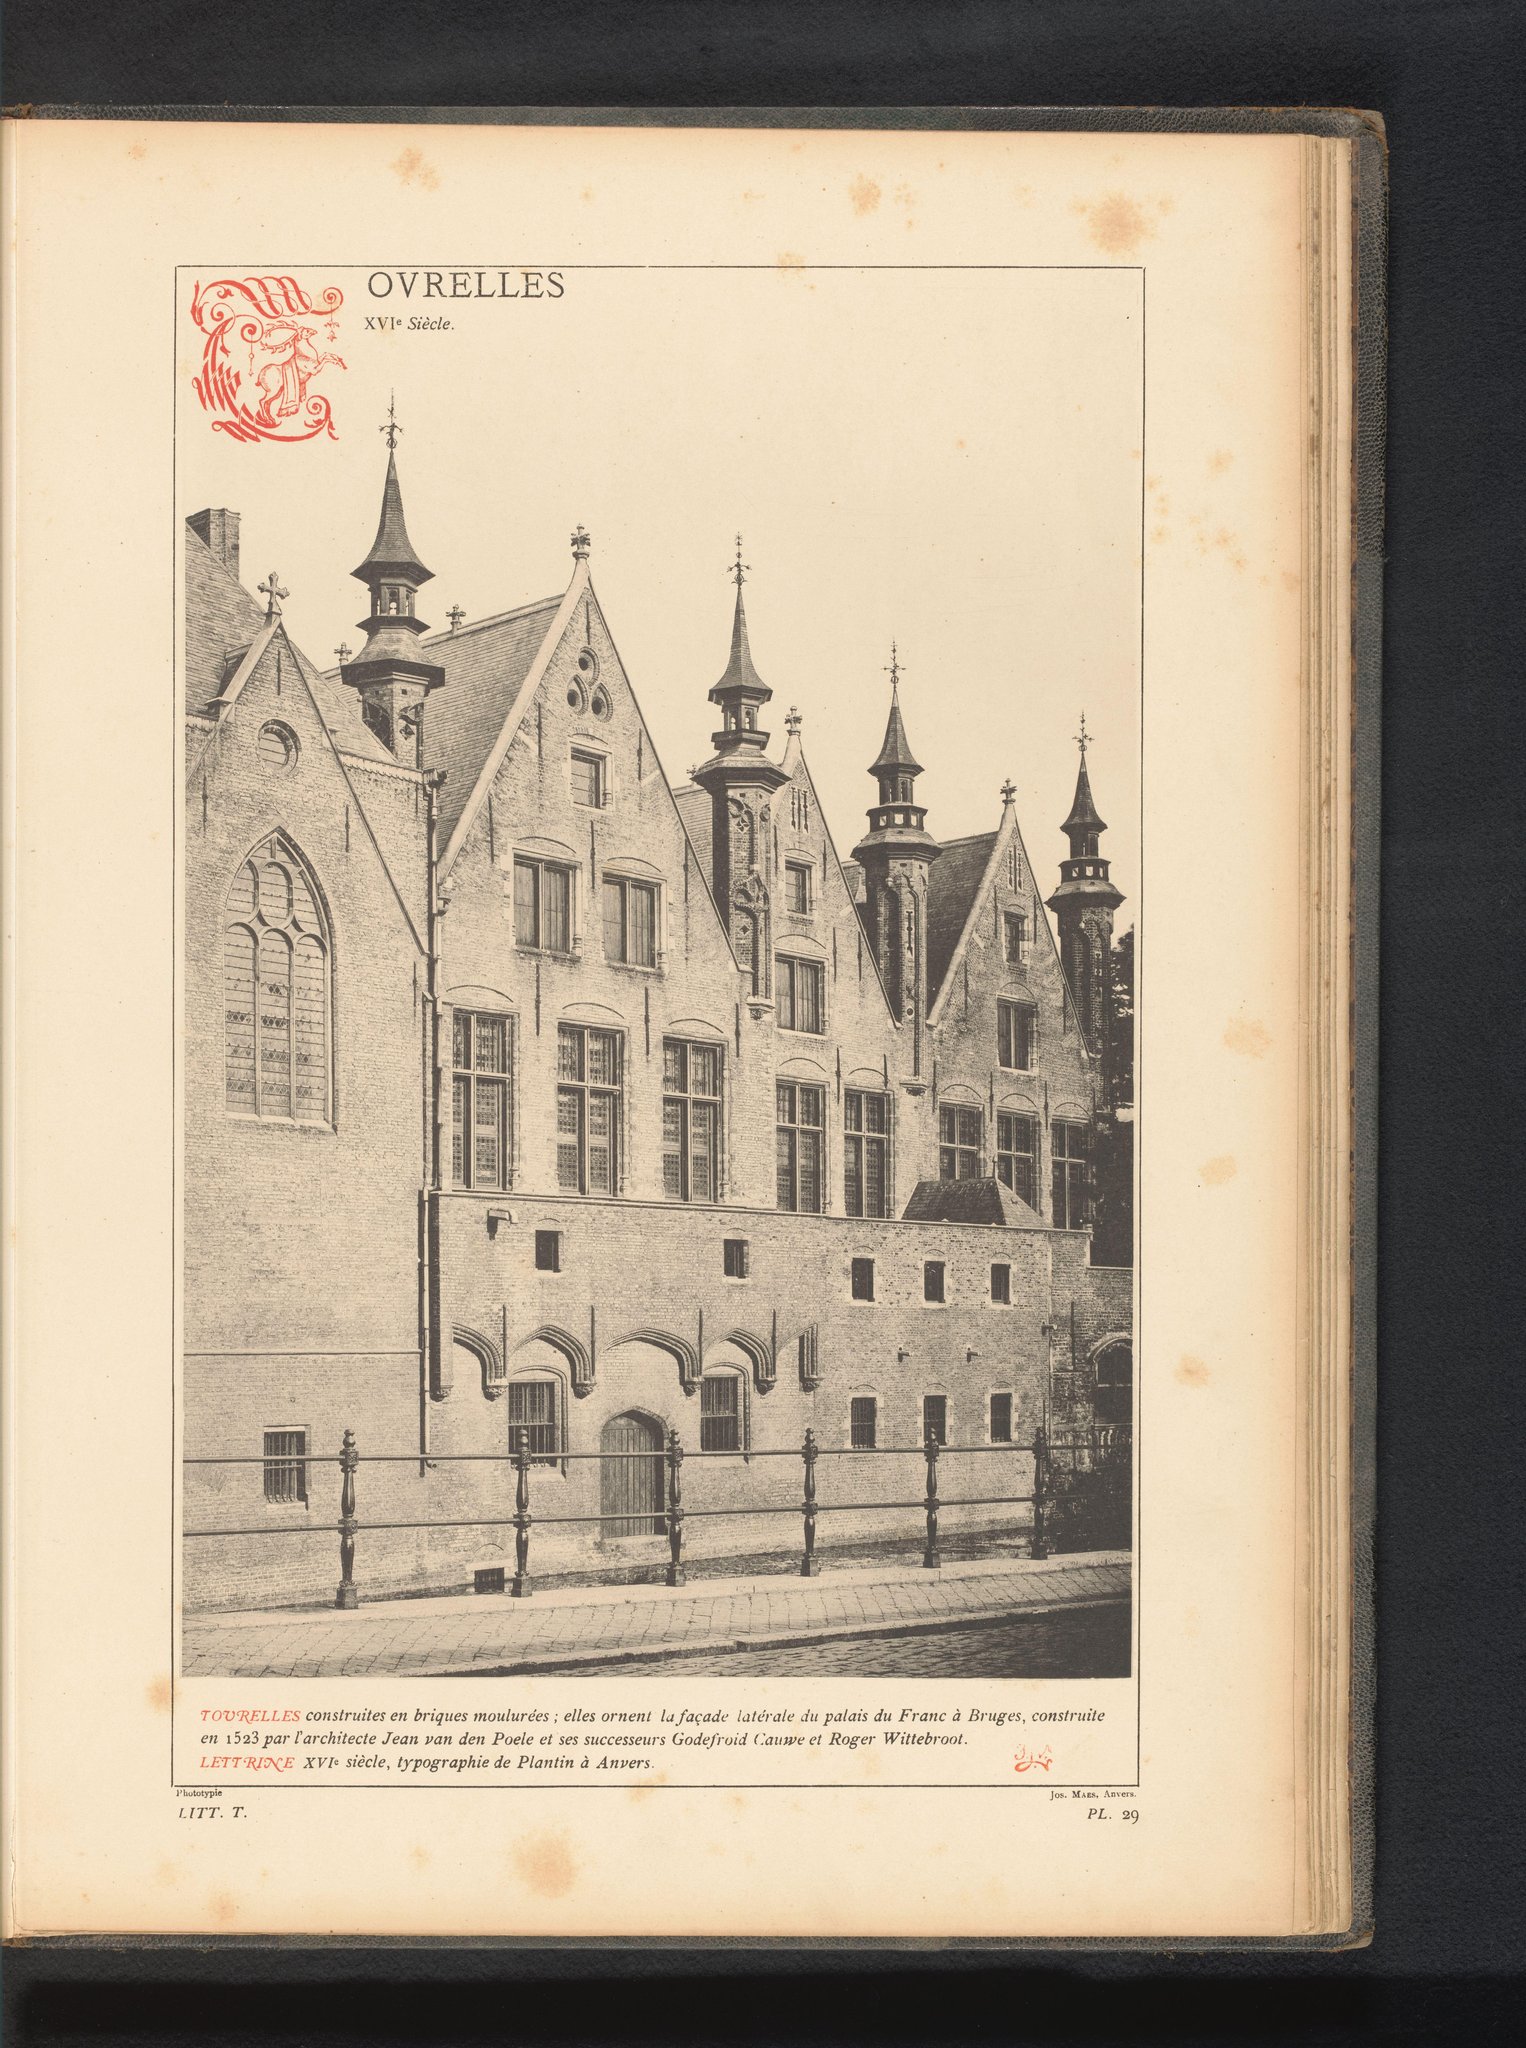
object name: page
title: Gezicht op het Landhuis van de Brugse Vrije te Brugge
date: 1876-1881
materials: paper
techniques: photograph, photolithography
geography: bruges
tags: façade (of house or building), bruges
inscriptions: inscription: ‘TOURELLES construites en (...)’, monogram: ‘JJvY’, inscription: ‘LITT. T. - PL. 29.’